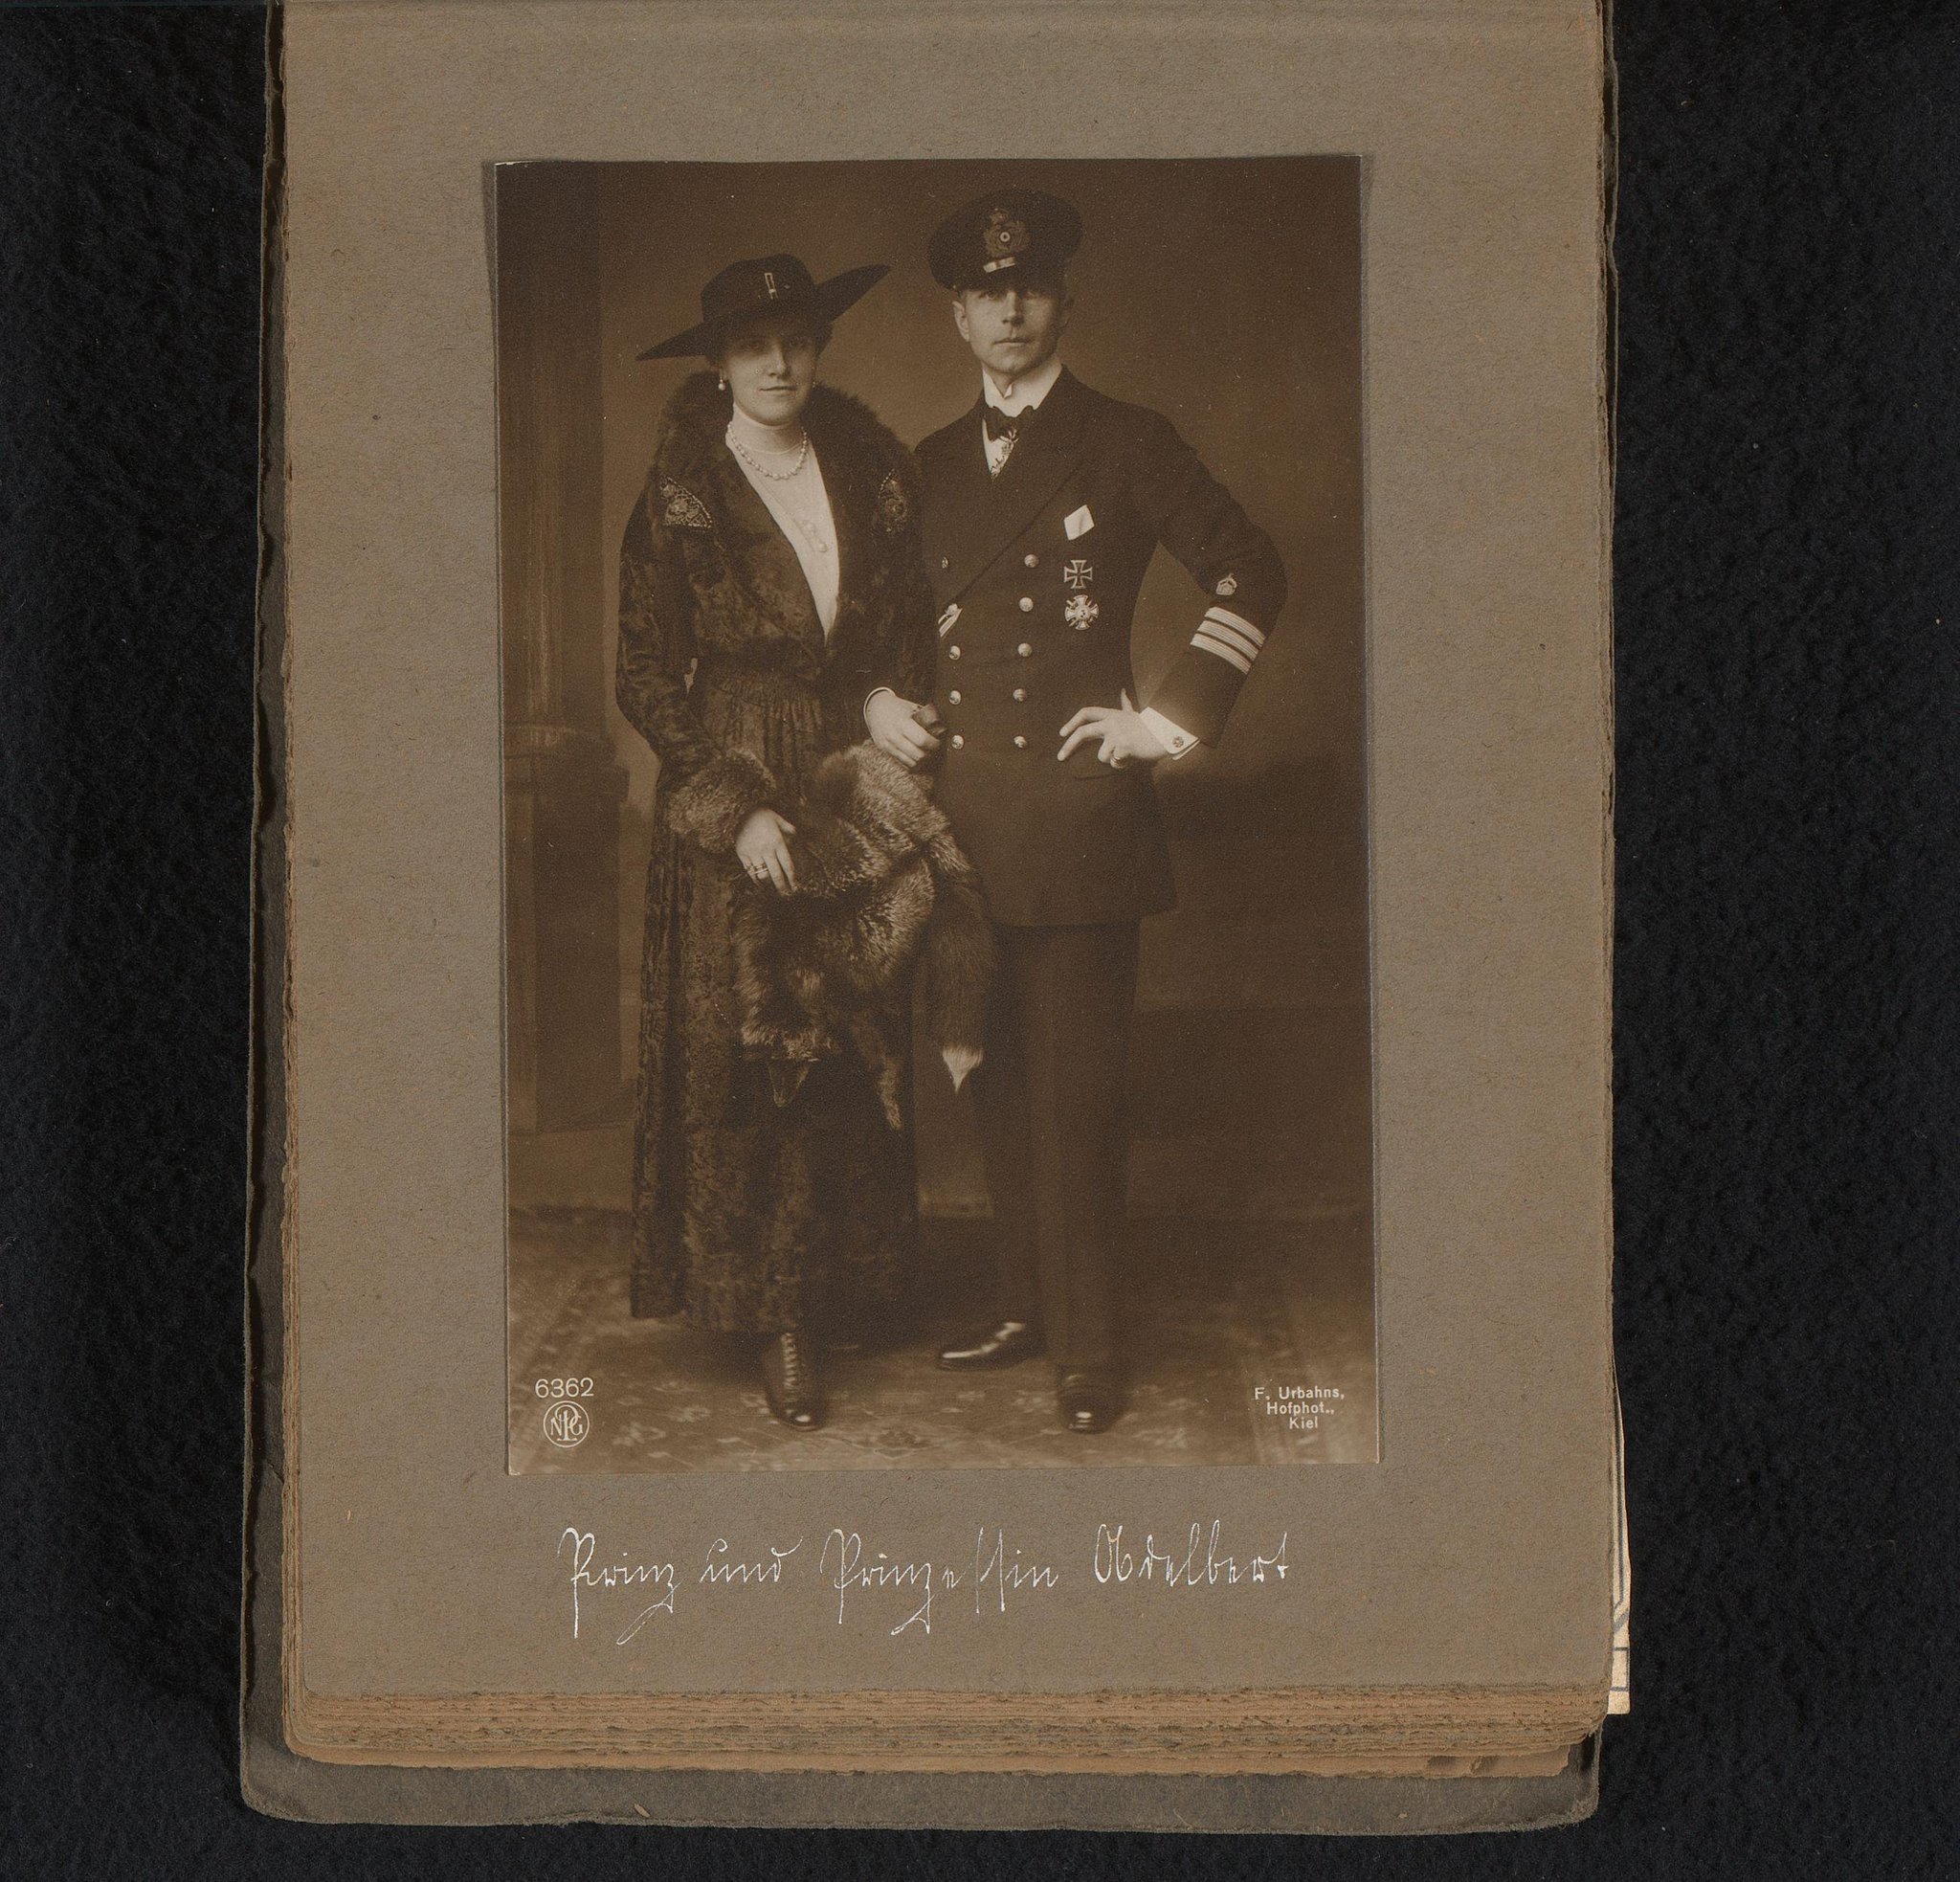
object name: photograph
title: Portret van Adalbert van Pruisen en zijn vrouw Adelheid Arna van Saksen-Meiningen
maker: ferdinand urbahns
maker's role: fotograaf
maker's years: 1863-1944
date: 1914-1918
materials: paper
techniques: gelatin silver print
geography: berlin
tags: prince, historical persons, princess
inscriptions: number: ‘6362’